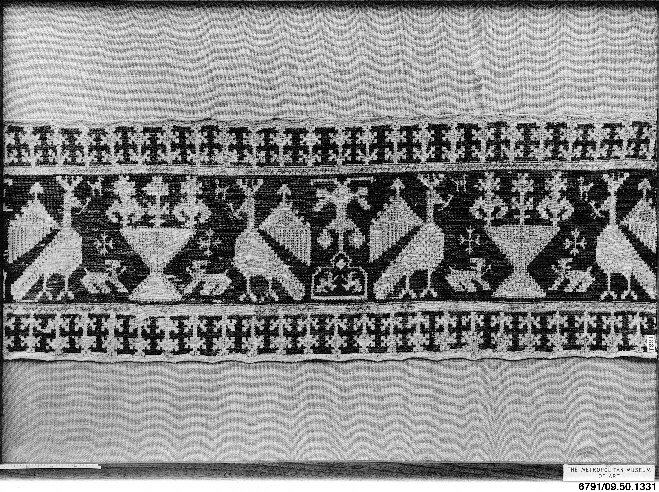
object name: band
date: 1701-1800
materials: linen, silk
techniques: embroidery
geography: morocco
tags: birds